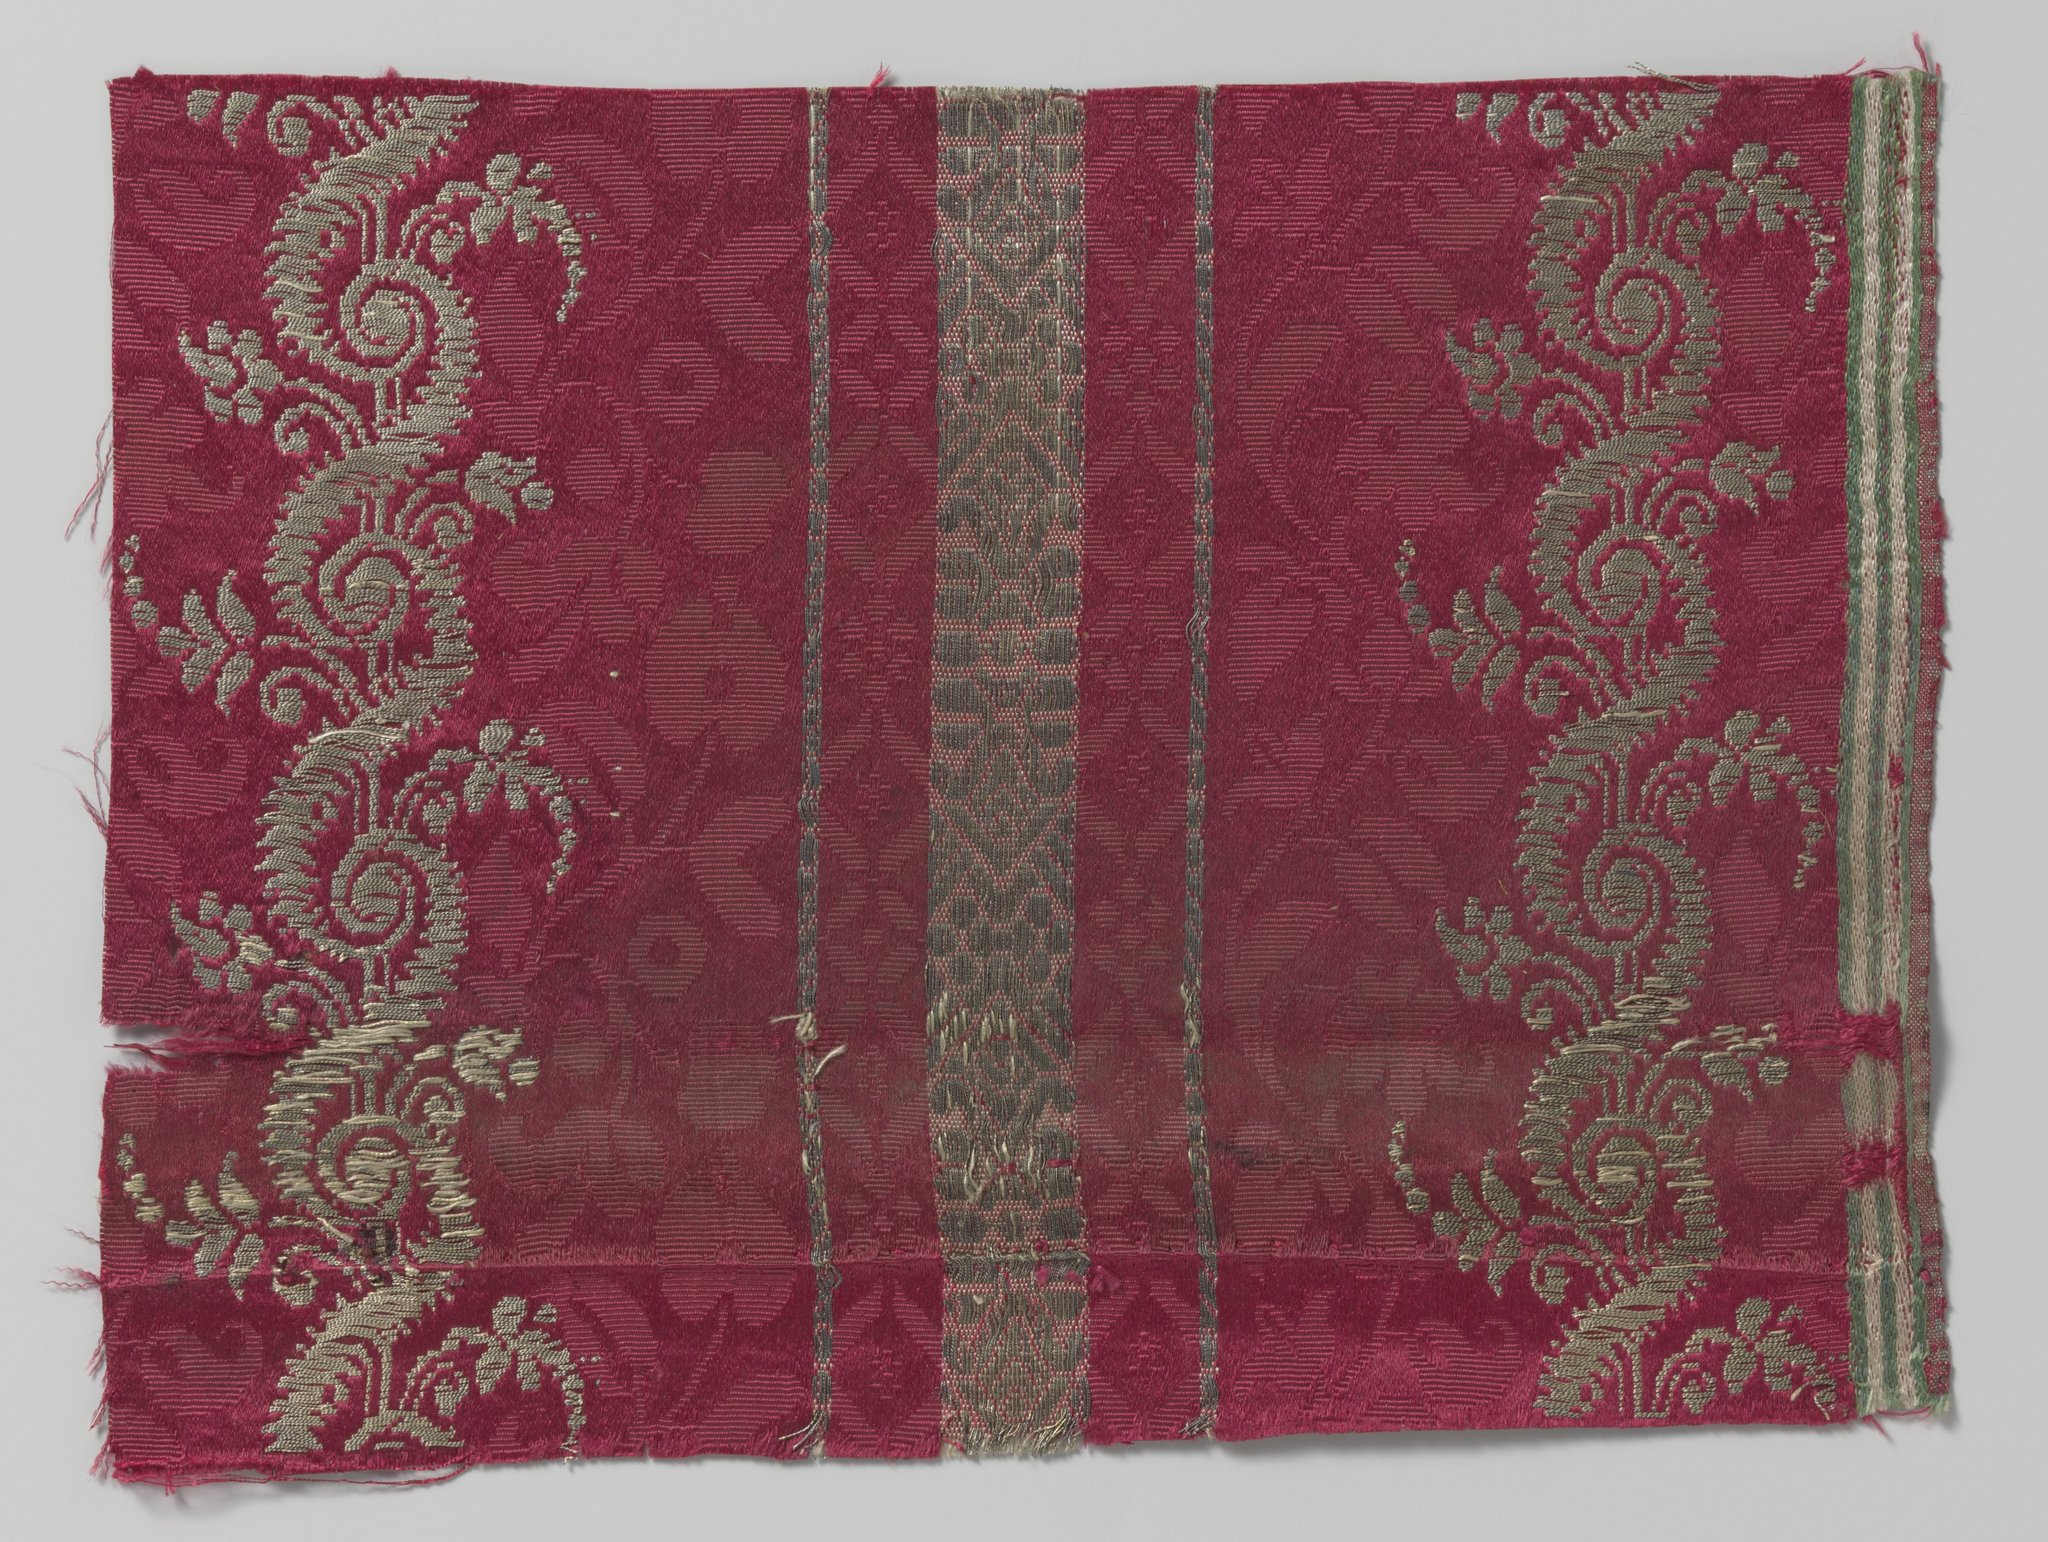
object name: zijdedamast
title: Fragment rode zijde met floraal patroon in zilverdraad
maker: Anonymous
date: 1600-1699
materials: silk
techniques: brocade, damask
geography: netherlands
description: Fragment van een zijdeweefsel; fond van rood satijn met rinceaux van rips, waarop van doorschoten zilver, verticale strepen, die passement imiteren en met omgekeerd S-vormige krullen omslingerde lijnen.